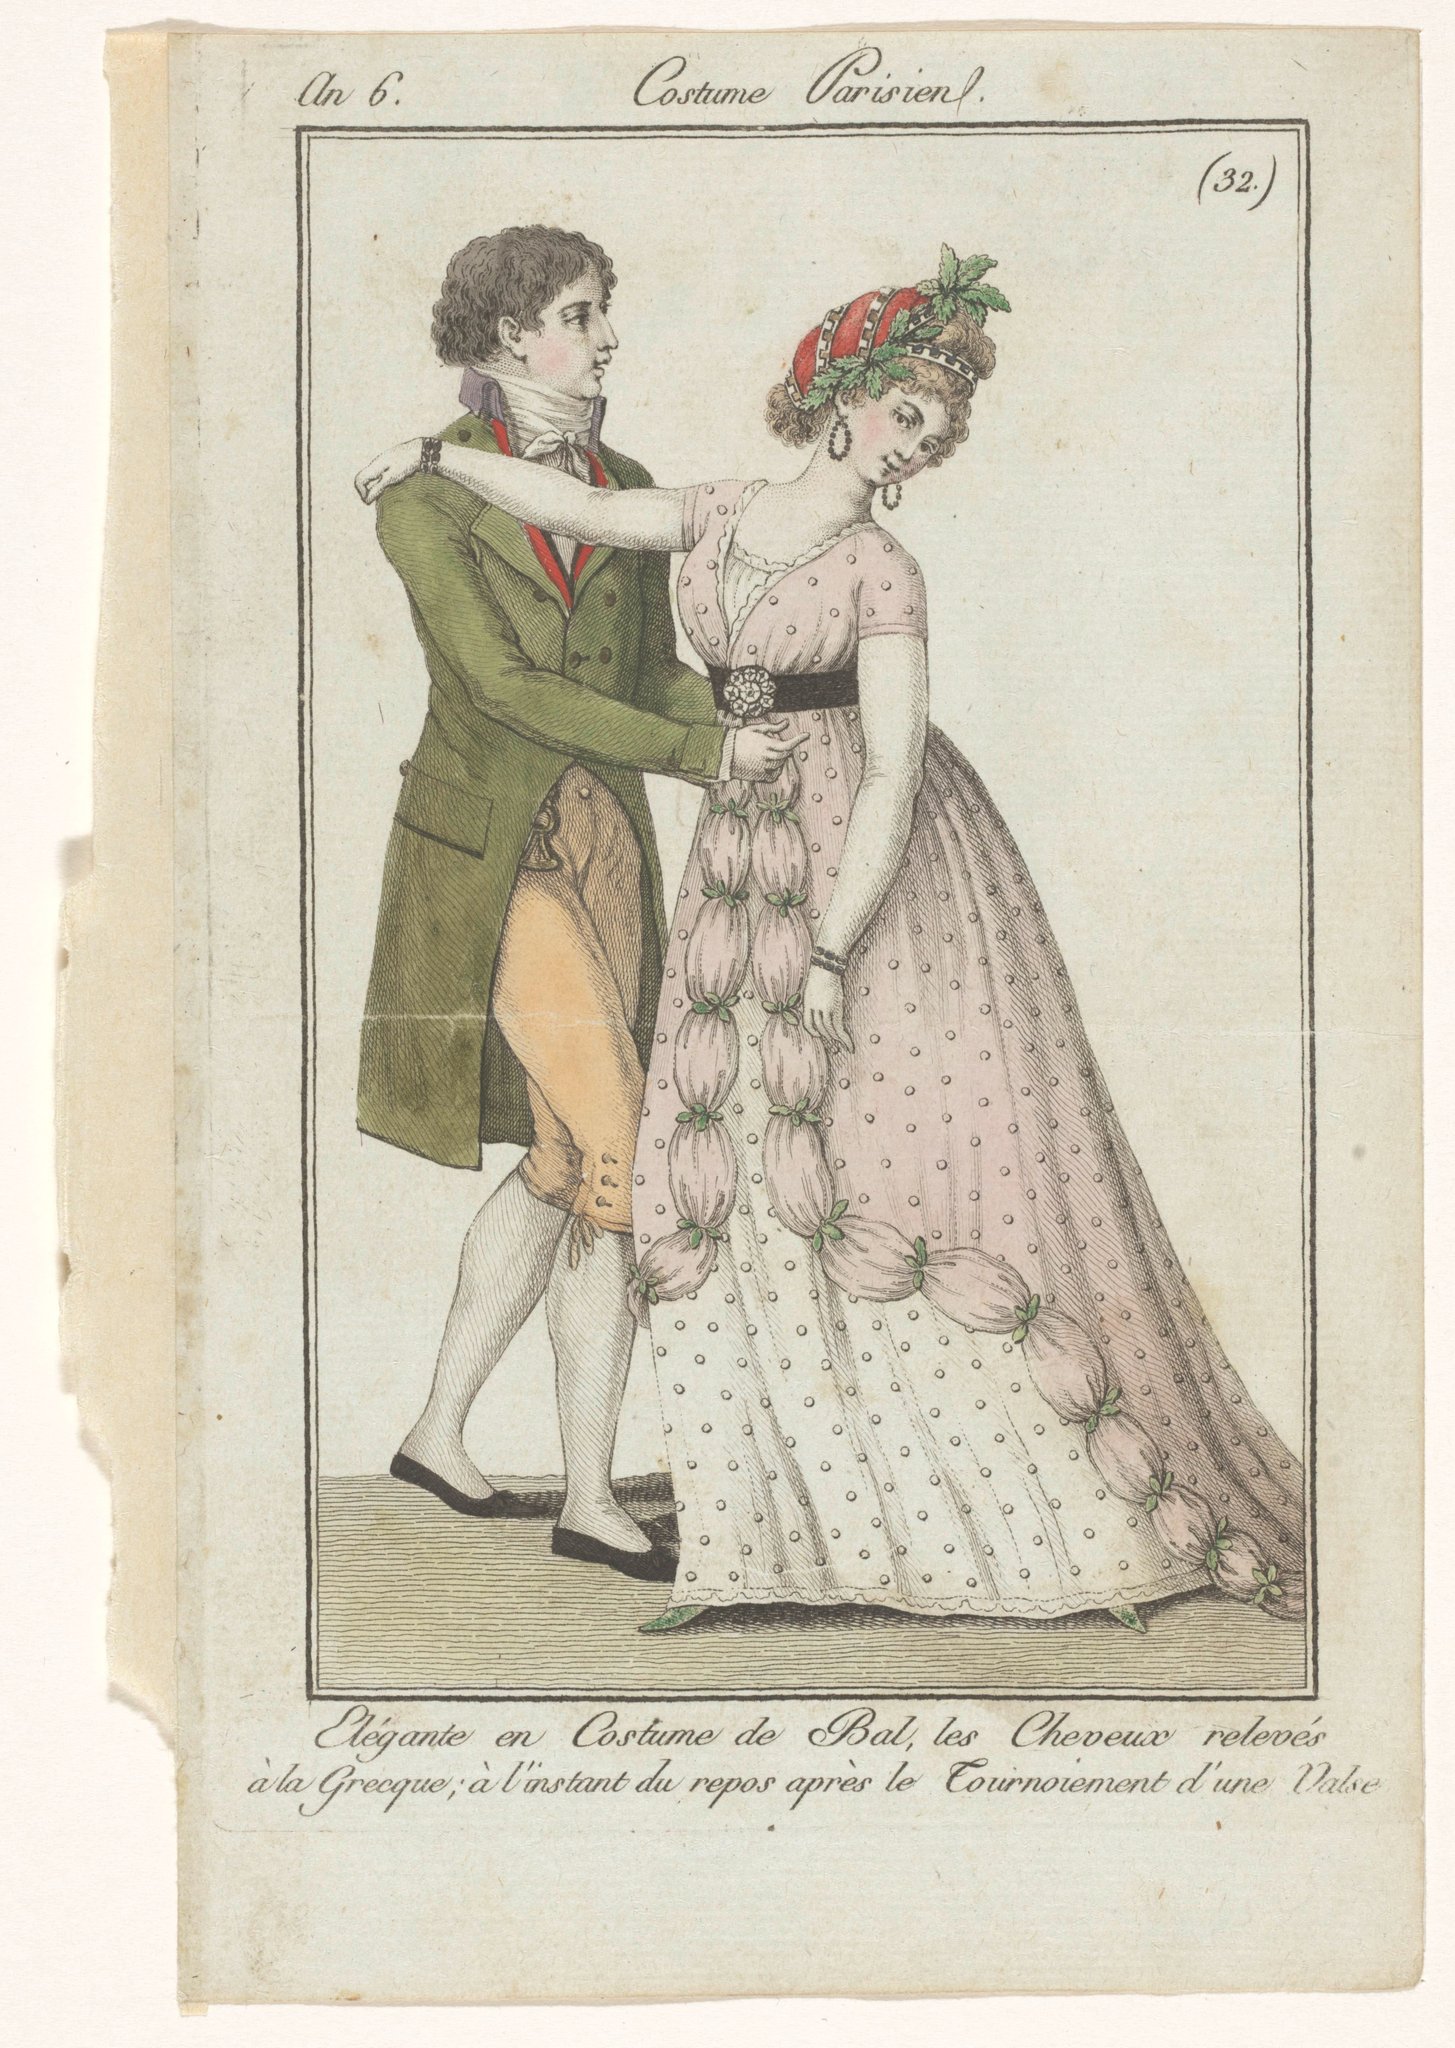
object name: fashion print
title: Paar in balkostuum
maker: Anonymous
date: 1797-1798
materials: paper, ink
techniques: etching, hand coloring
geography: france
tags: fashion plates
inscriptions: collector's mark: Lugt 2228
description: Dansend paar in balkostuum. Prent genomen uit Journal des Dames et des Modes, Costume Parisien, An. 6 [1797-1798], 32.